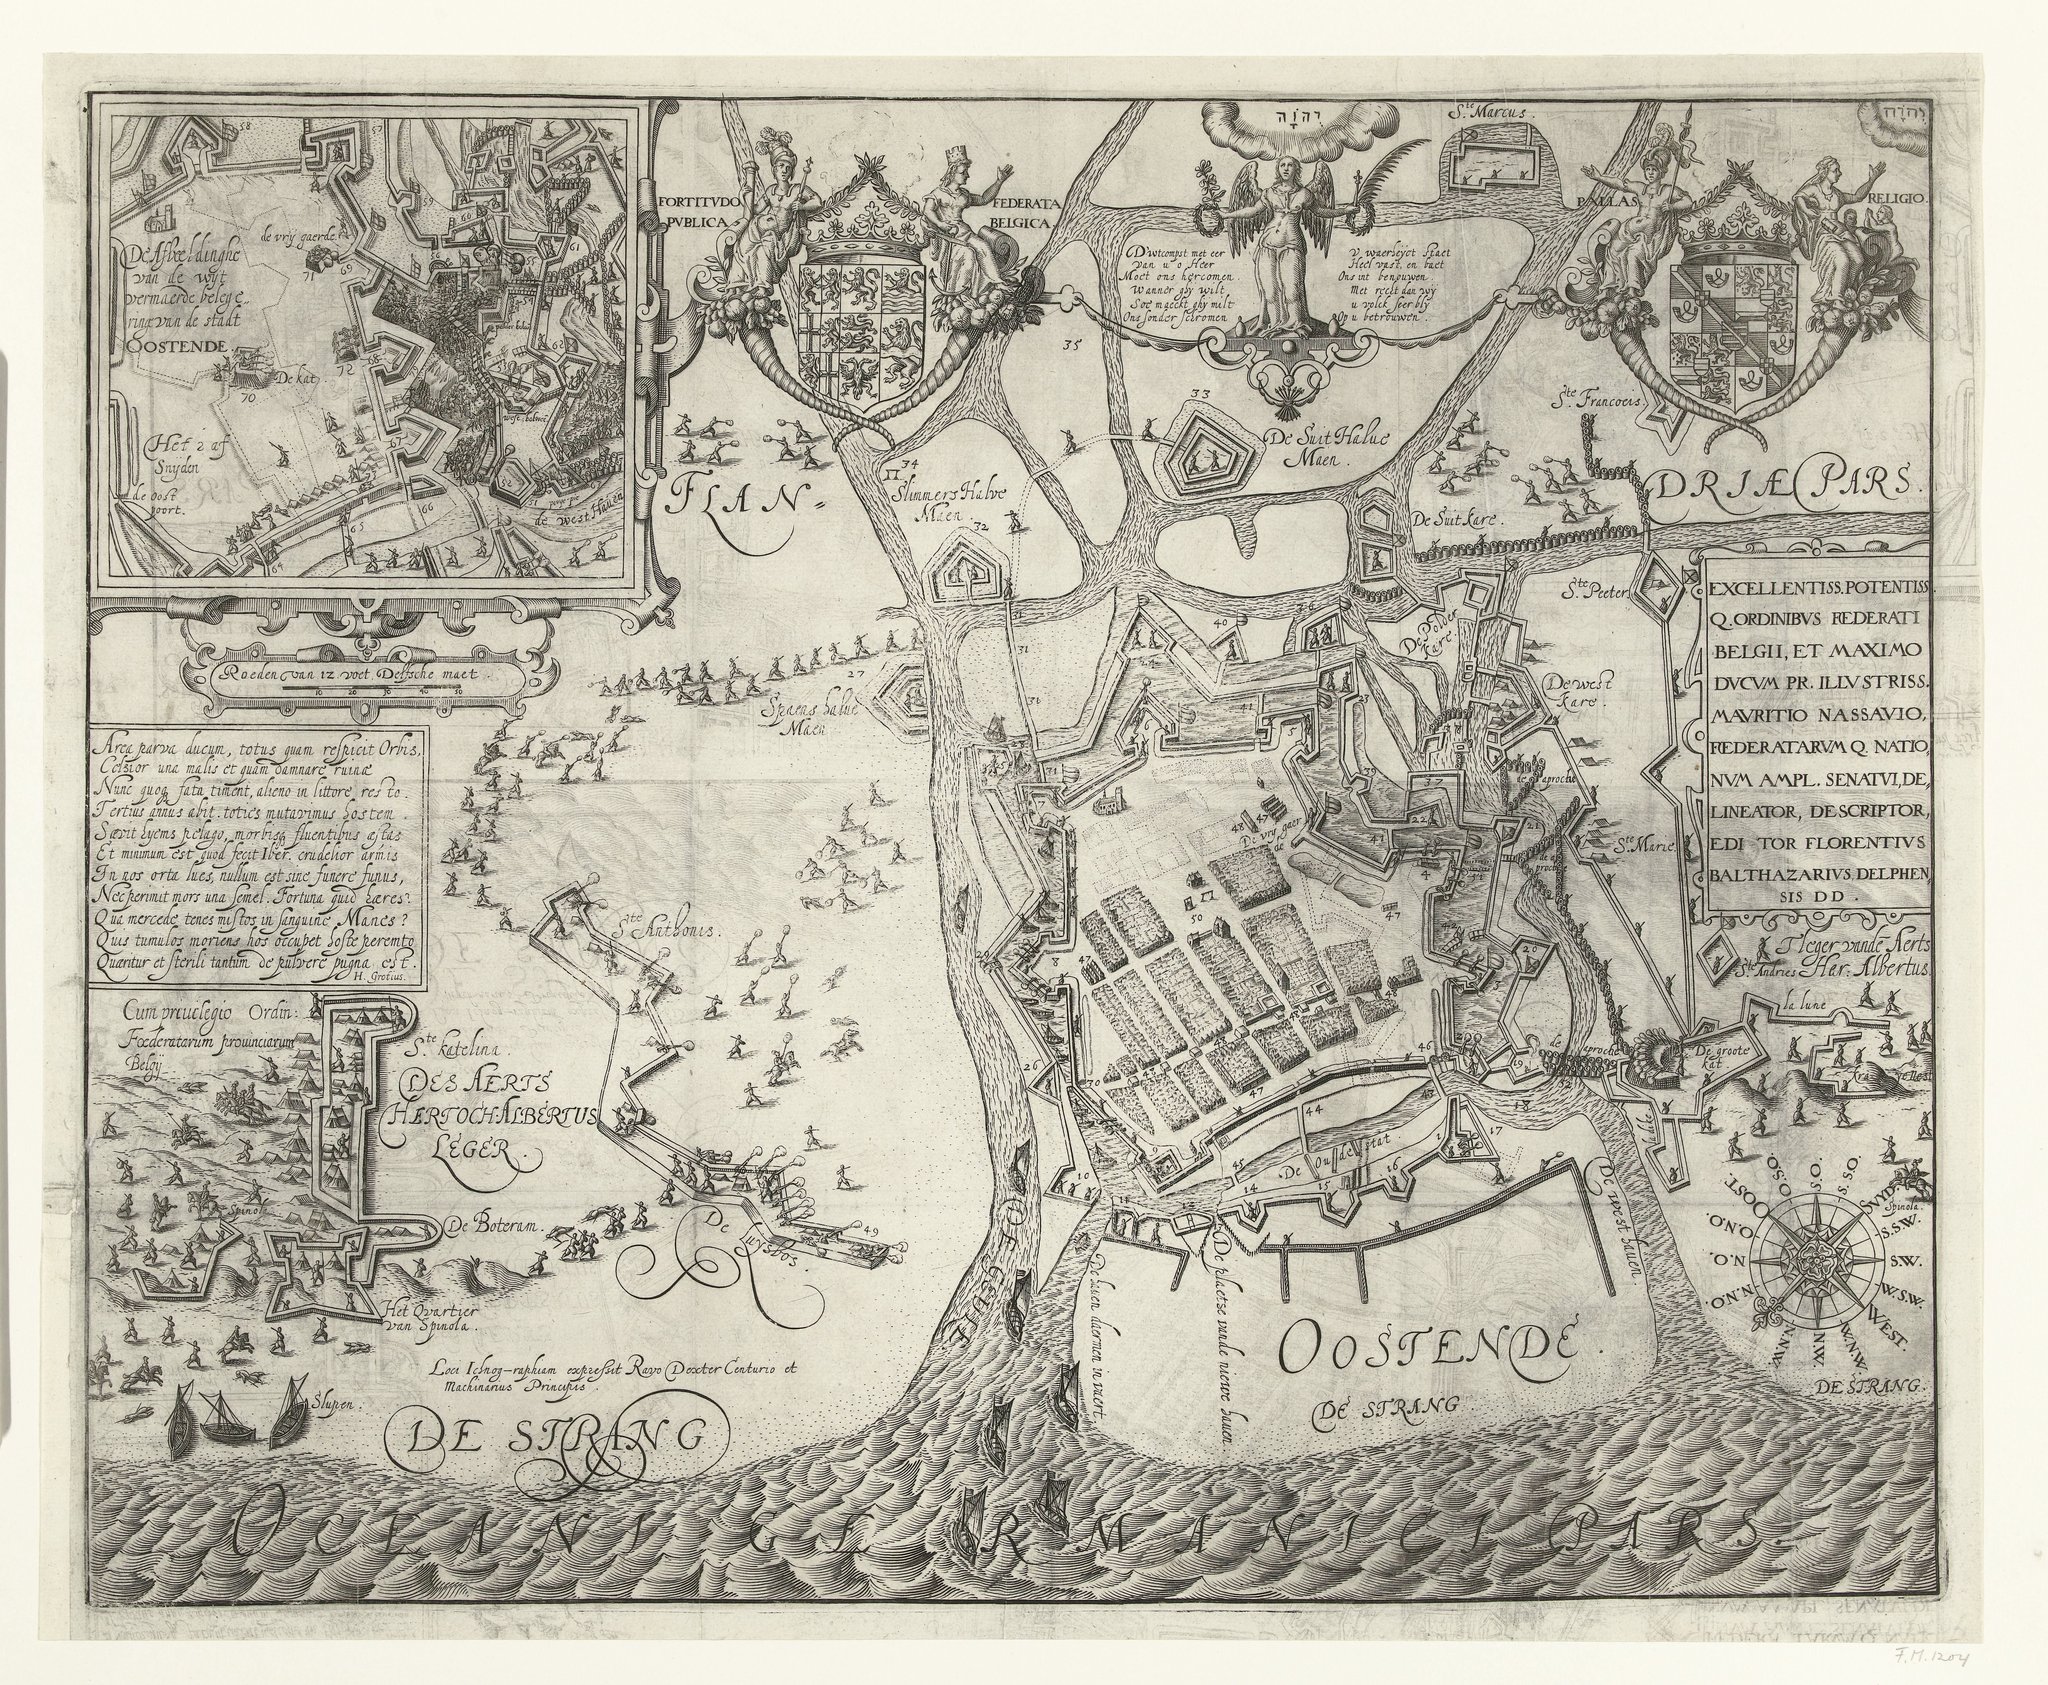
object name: map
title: De Afbeeldinghe van de wijt vermaerde belegering van de stad Oostende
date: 1603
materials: paper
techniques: engraving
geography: northern netherlands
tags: brussels, albrecht aartshertog van oostenrijk, maps of separate countries or regions, siege, position war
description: Beleg van Oostende door het Spaanse leger onder Albrecht en later onder Spinola van 1601-1604. Plan van de stad en het omliggende gebied. Links en rechts de posities van de belegeraars. Links cartouches met een kaartje met de strijd aan de zuidzijde van de schansen en met een vers van 11 regels in het Latijn. Bovenaan het wapen van de Staten-Generaal, met personificaties de Kracht van het Volk (Fortitudo Publica) en de Verenigde Nederlanden (Federata Belgica), daarnaast het wapen van Maurits met Pallas en de personificatie van Geloof (Religio). In het midden een staande engel onder het tetragram. Rechts een cartouche met de opdracht in het Latijn. Onderaan het strand. Details genummerd in de voorstelling maar een legenda ontbreekt.